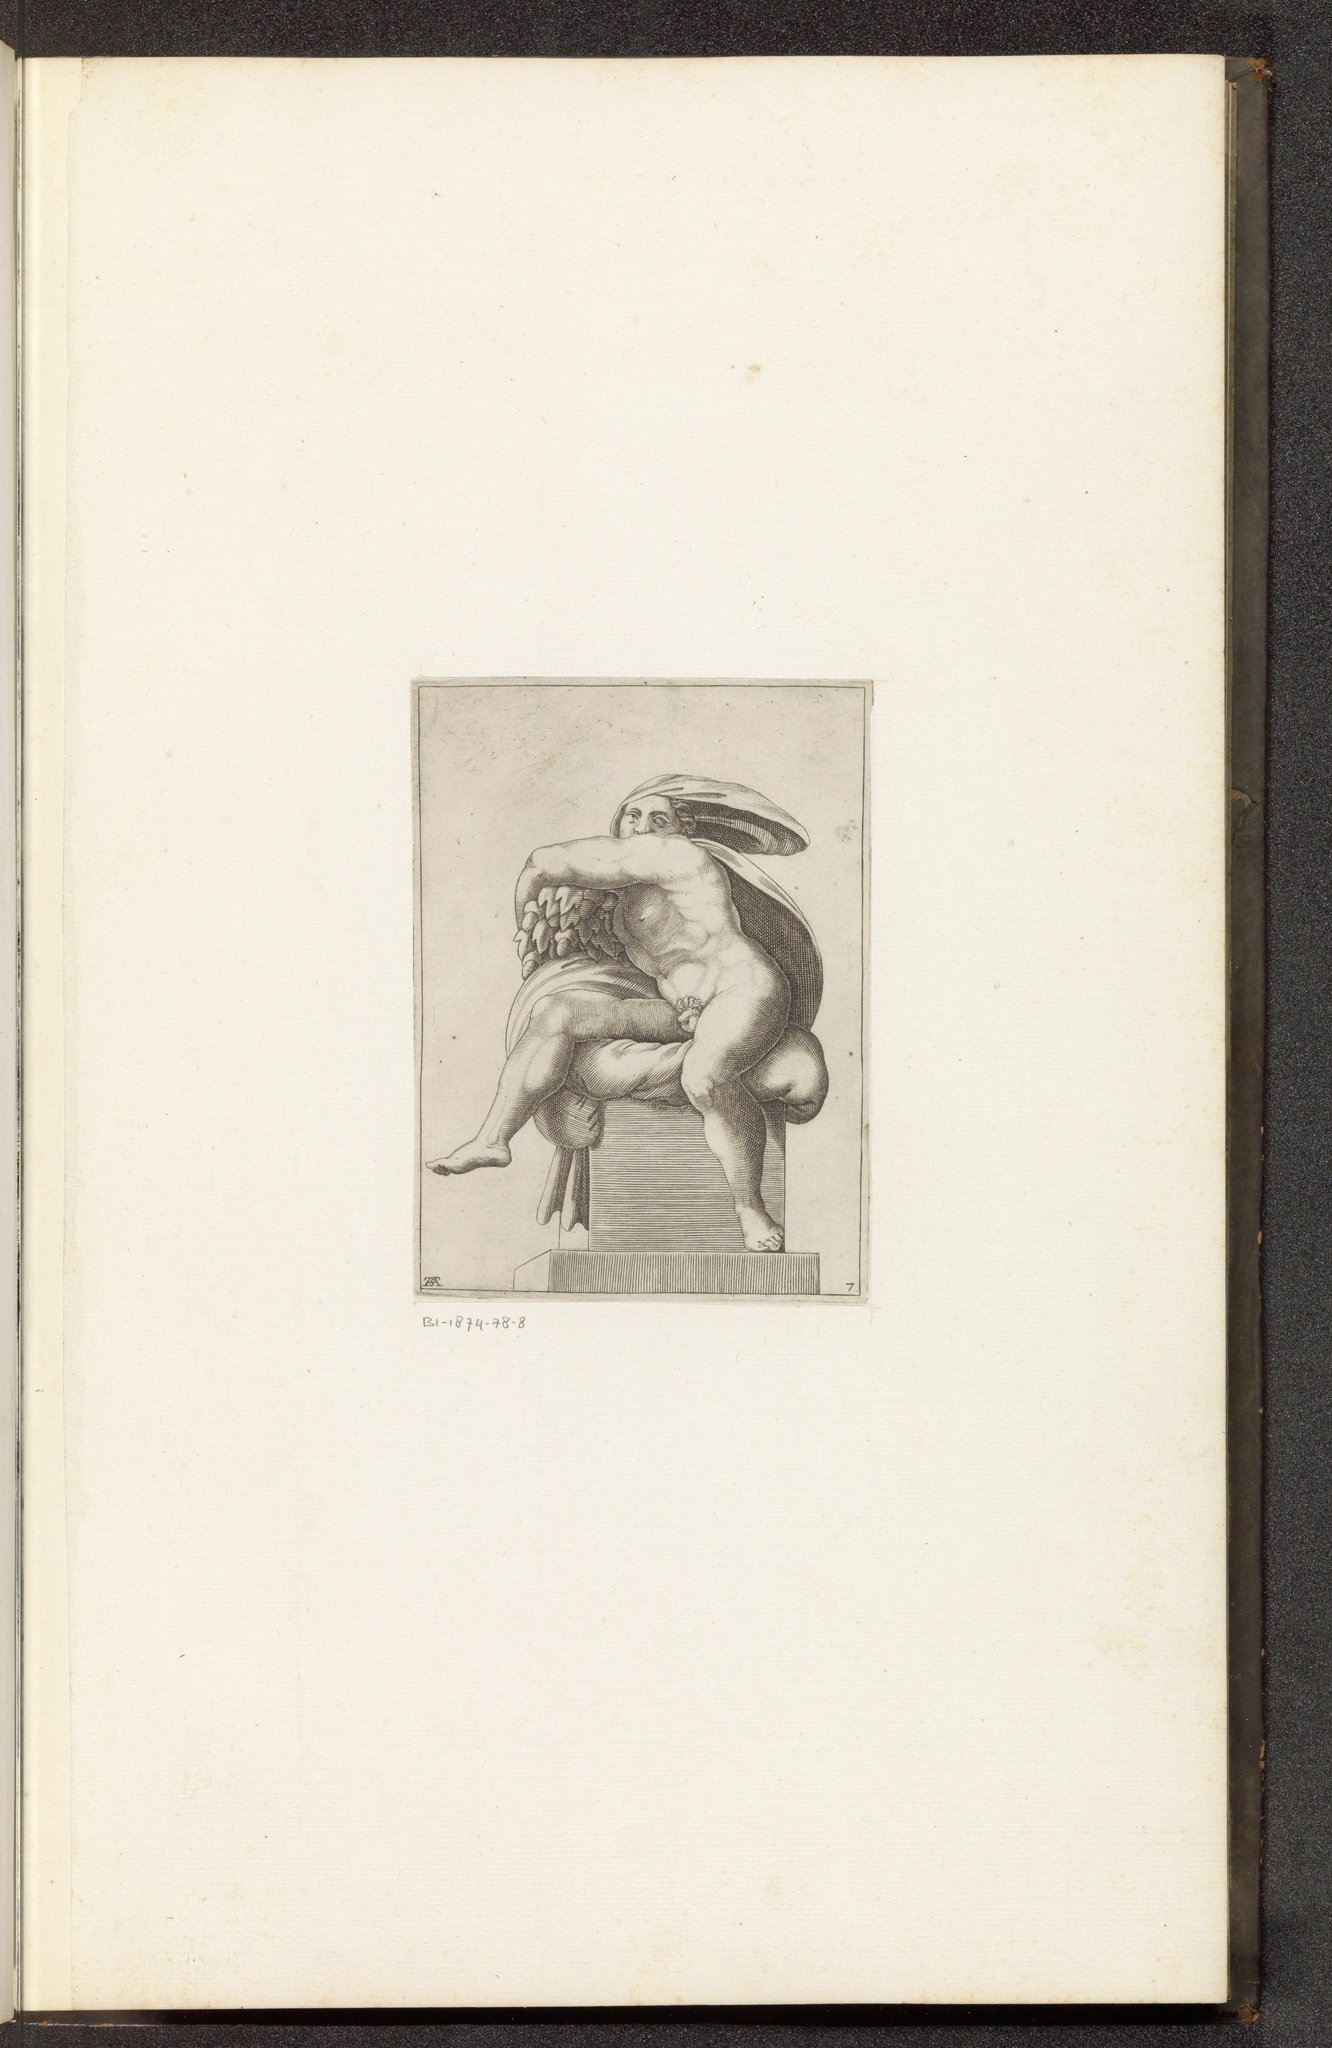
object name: album leaf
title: Schilderingen in de Sixtijnse kapel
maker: adamo scultori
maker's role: painter, print maker, sculptor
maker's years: 1530-1585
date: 1585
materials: paper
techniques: engraving, intaglio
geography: vatican city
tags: the (nude) human figure; 'corpo humano' (ripa), fruits: acorn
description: Naakte man zittend op een kussen, gedeeltelijk naar links gedraaid, met een guirlande van eikels. Eén van de 'ignudi' (naakte mannen) van Michelangelo's plafondschildering. Genummerd rechtsonder: 7. De prent maakt deel uit van een album.